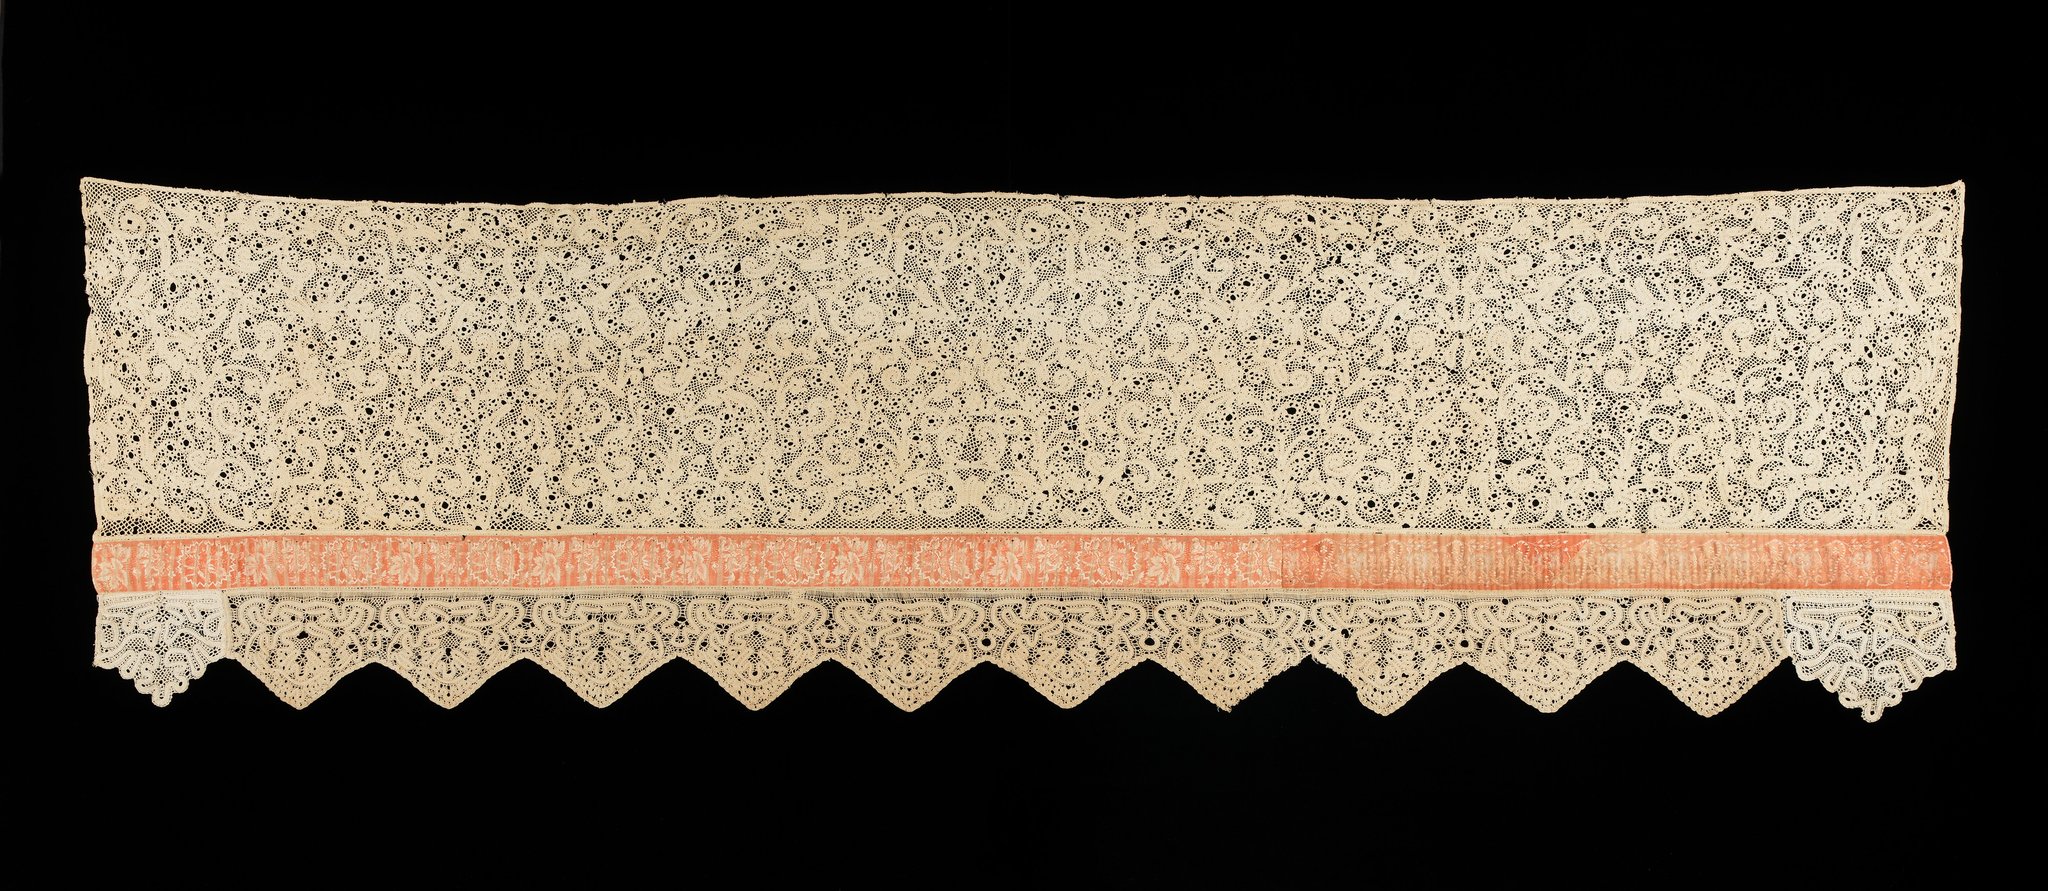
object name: border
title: Bed curtain border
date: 1790-1825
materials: linen, silk